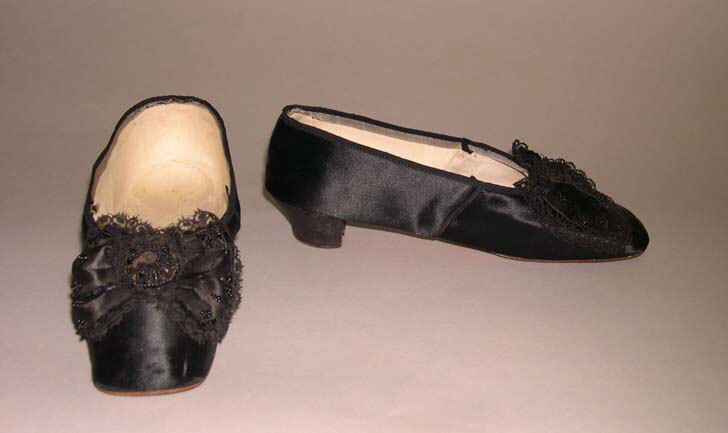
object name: slipper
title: Slippers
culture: american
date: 1850-1859